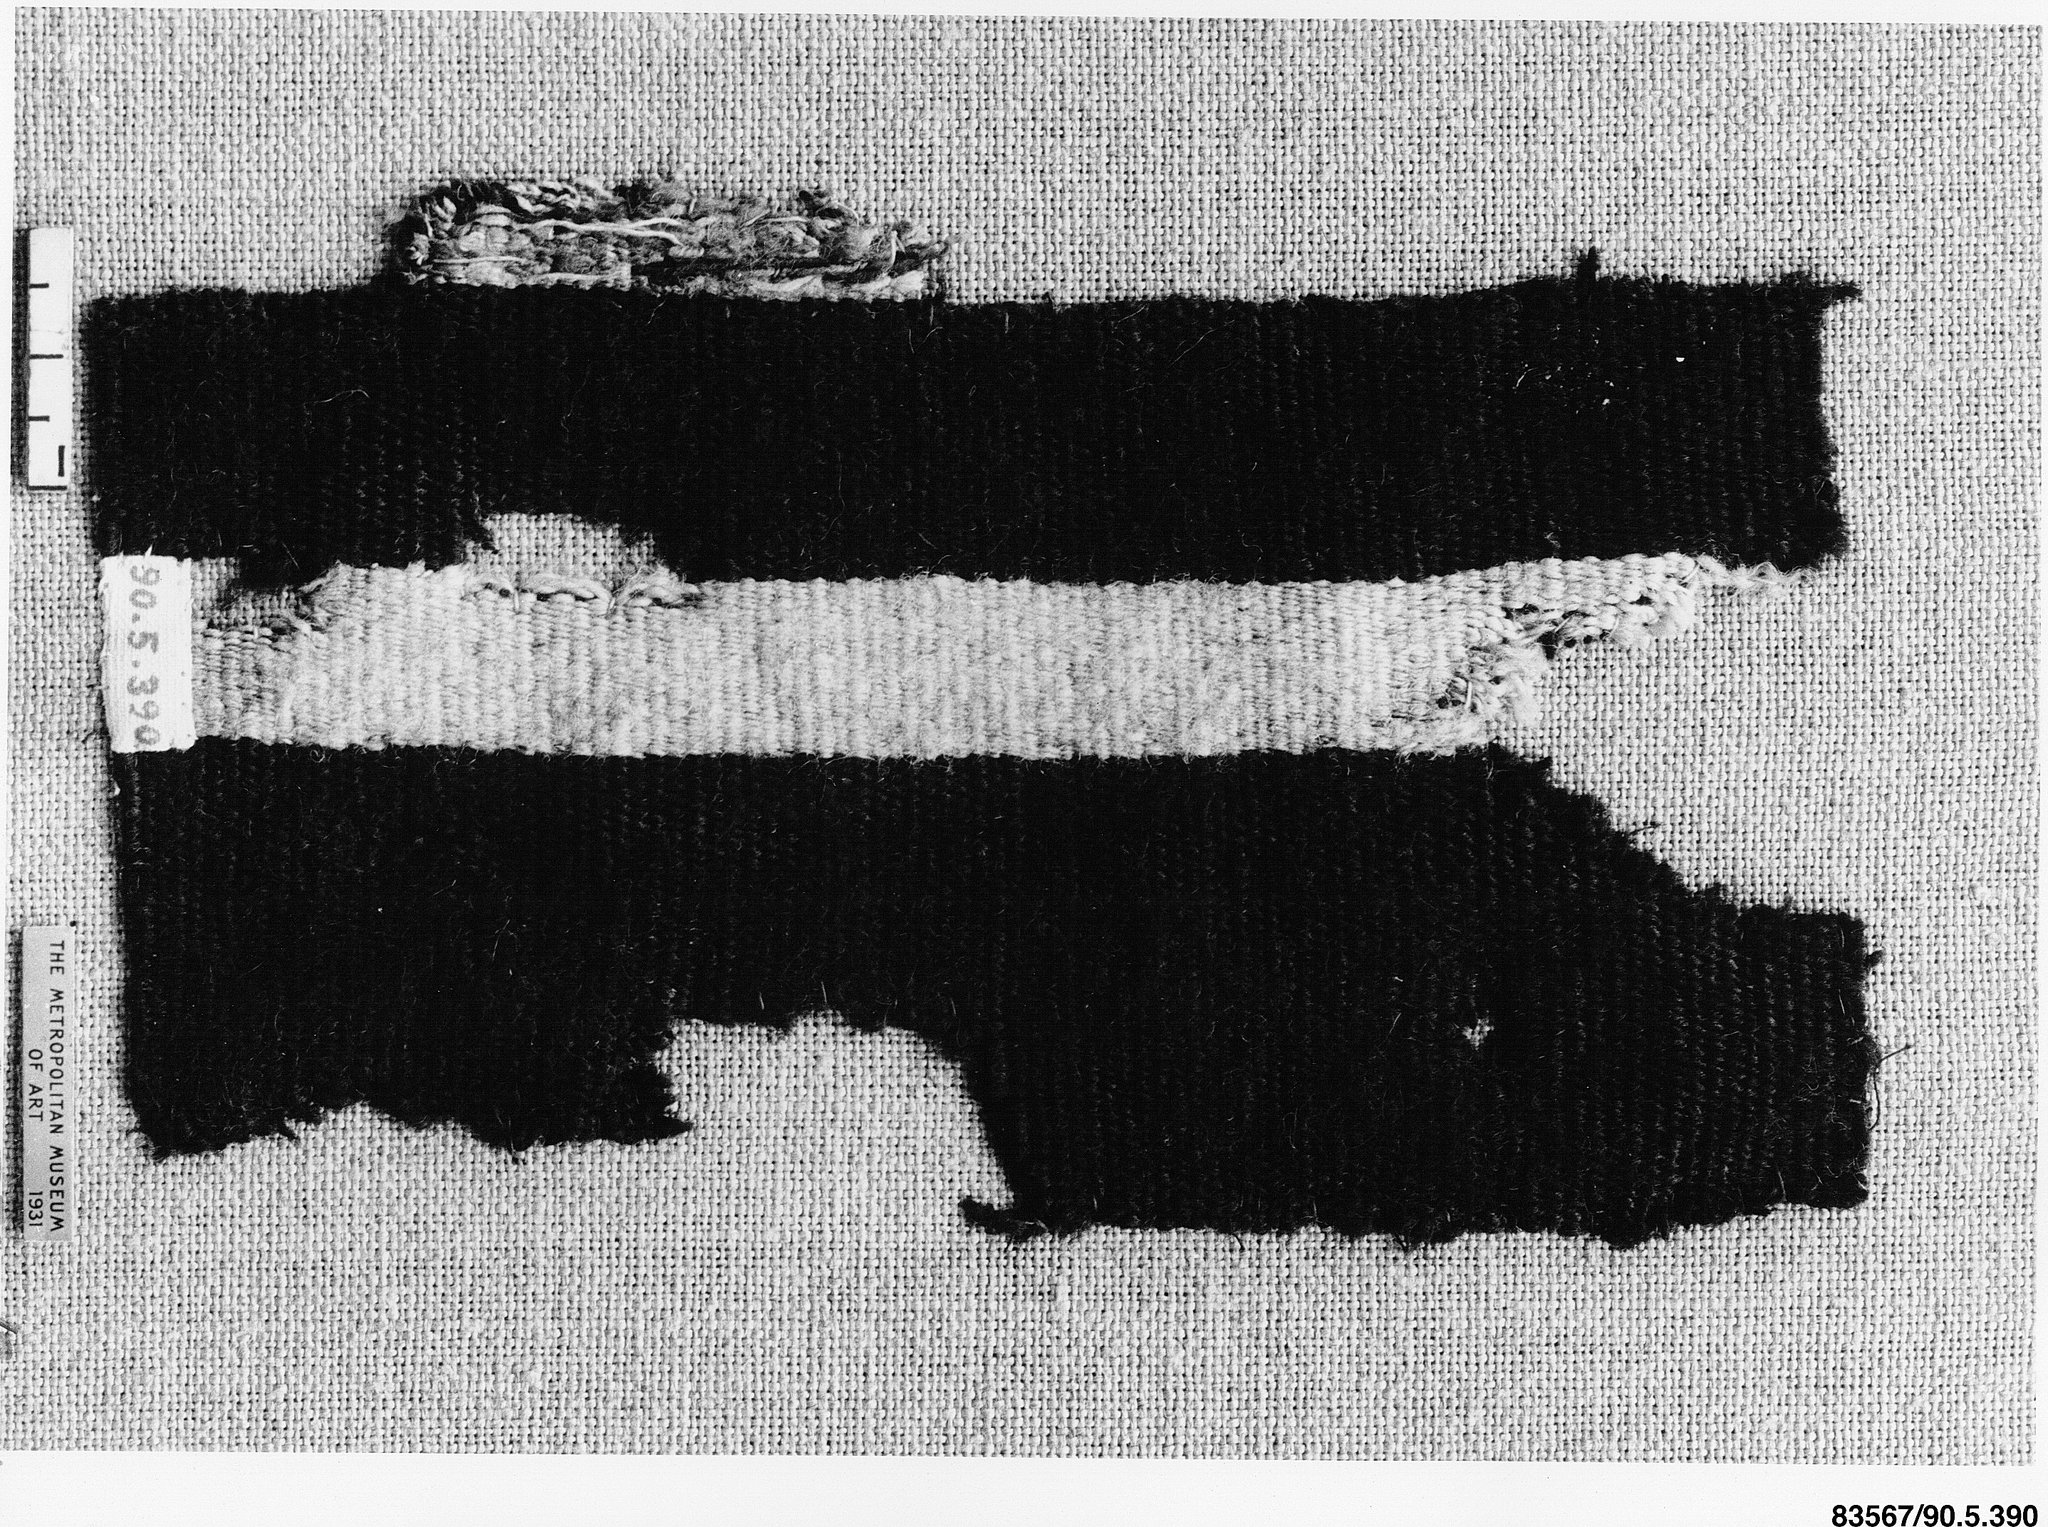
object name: textile fragment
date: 301-500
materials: wool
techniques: weave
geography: egypt